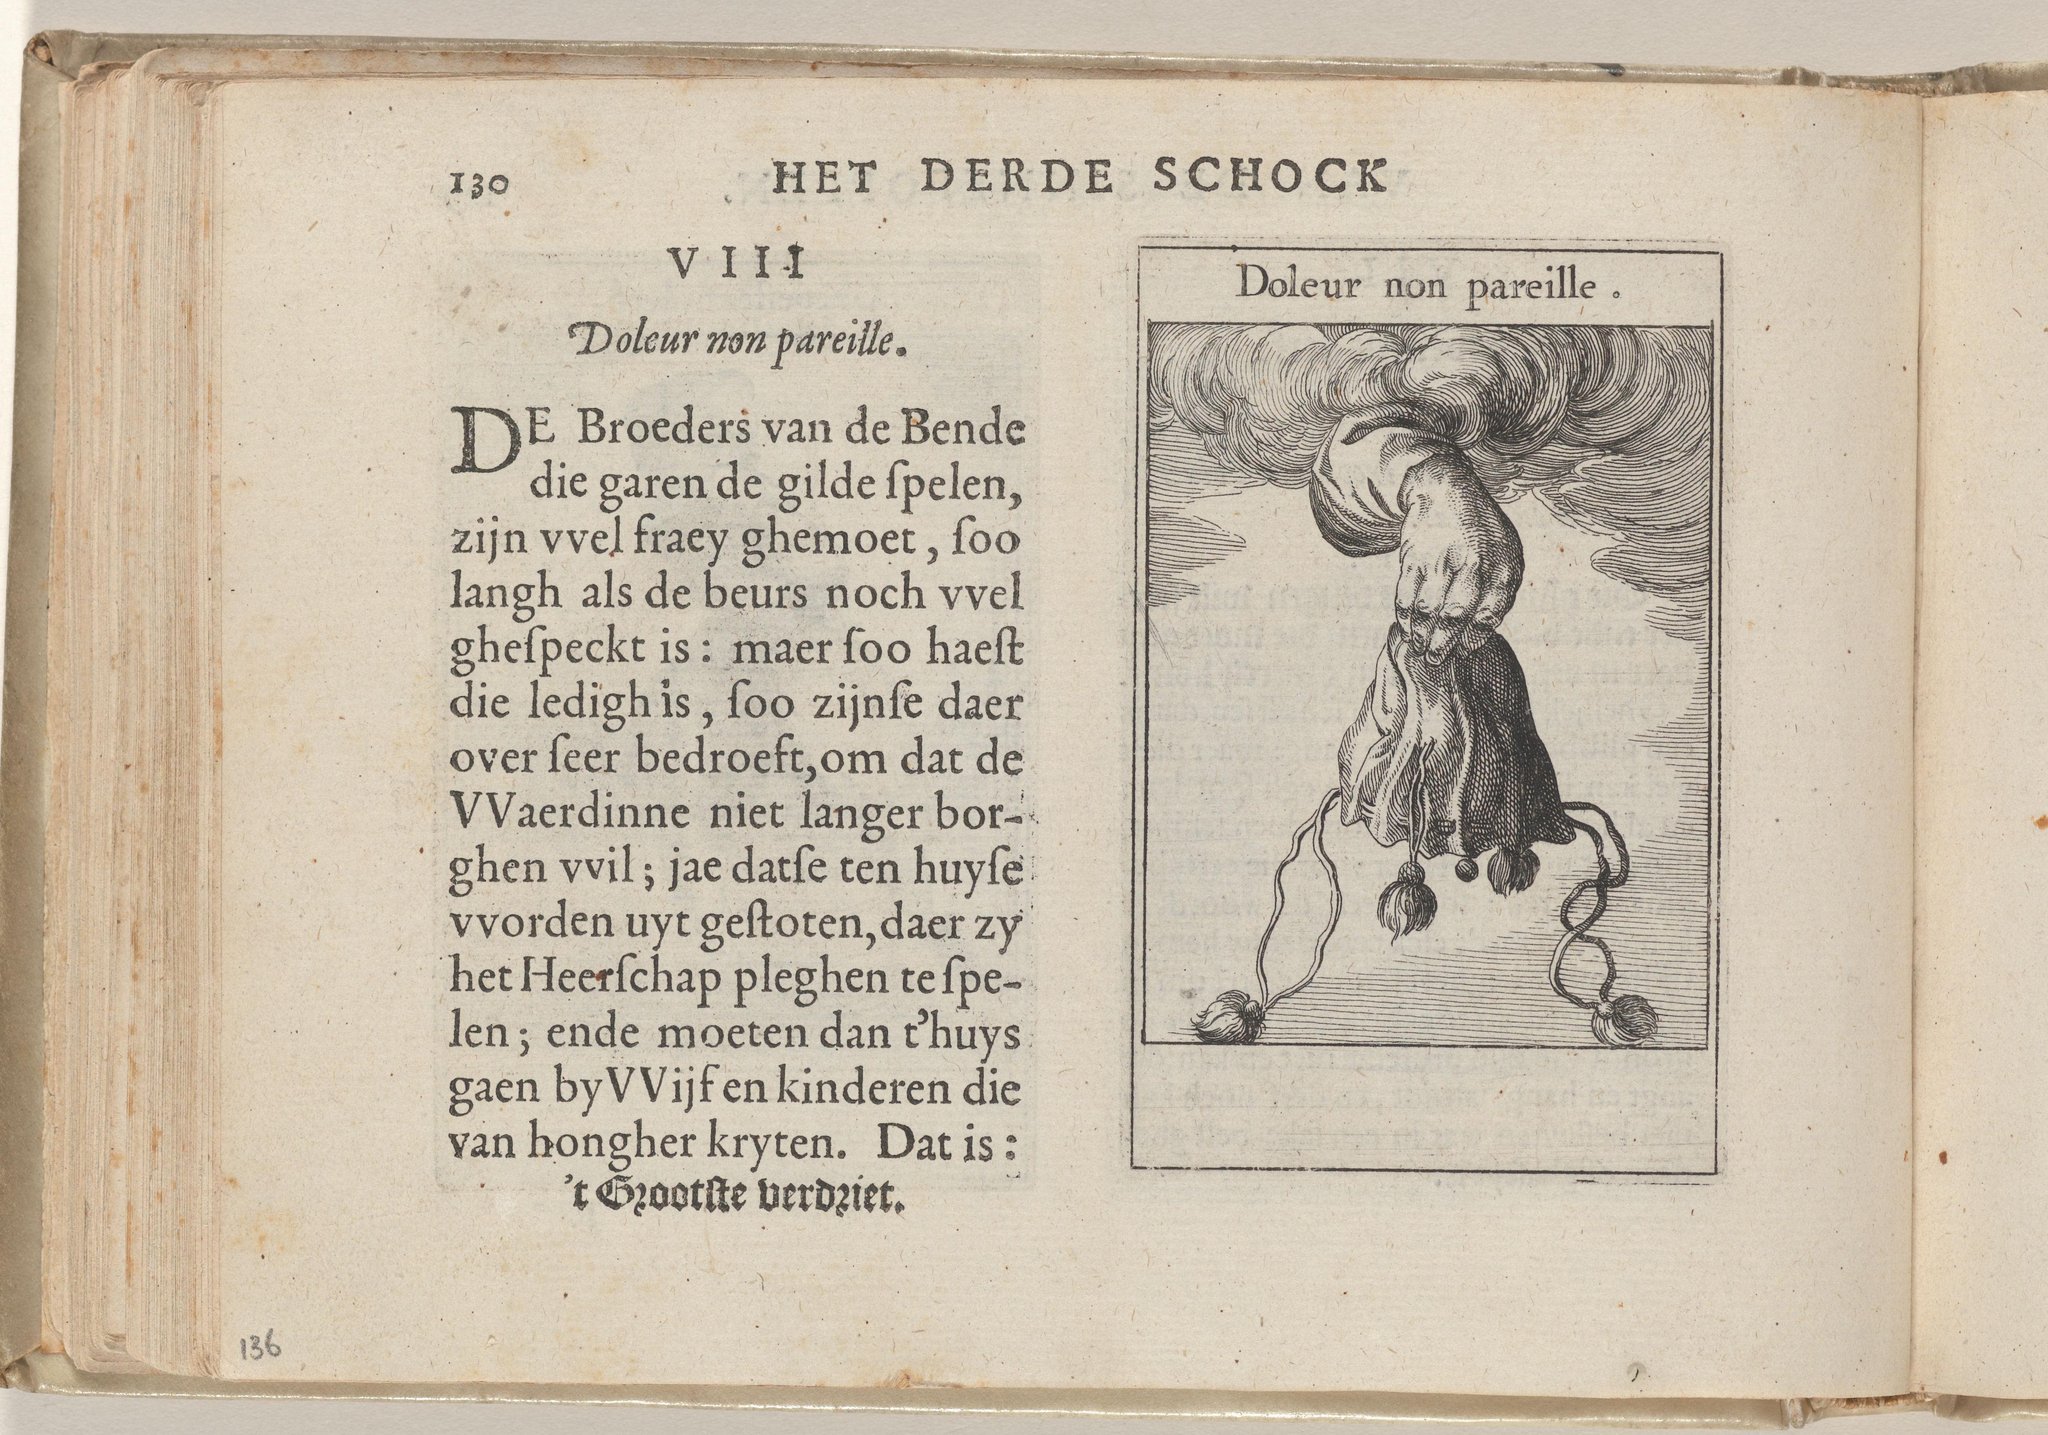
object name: album leaf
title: VIII Doleur non pareille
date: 1614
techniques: engraving, printing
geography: amsterdam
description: VIII Doleur non pareille. Derde schok. Onderdeel van 'Sinnepoppen', R. Visscher, 1614.